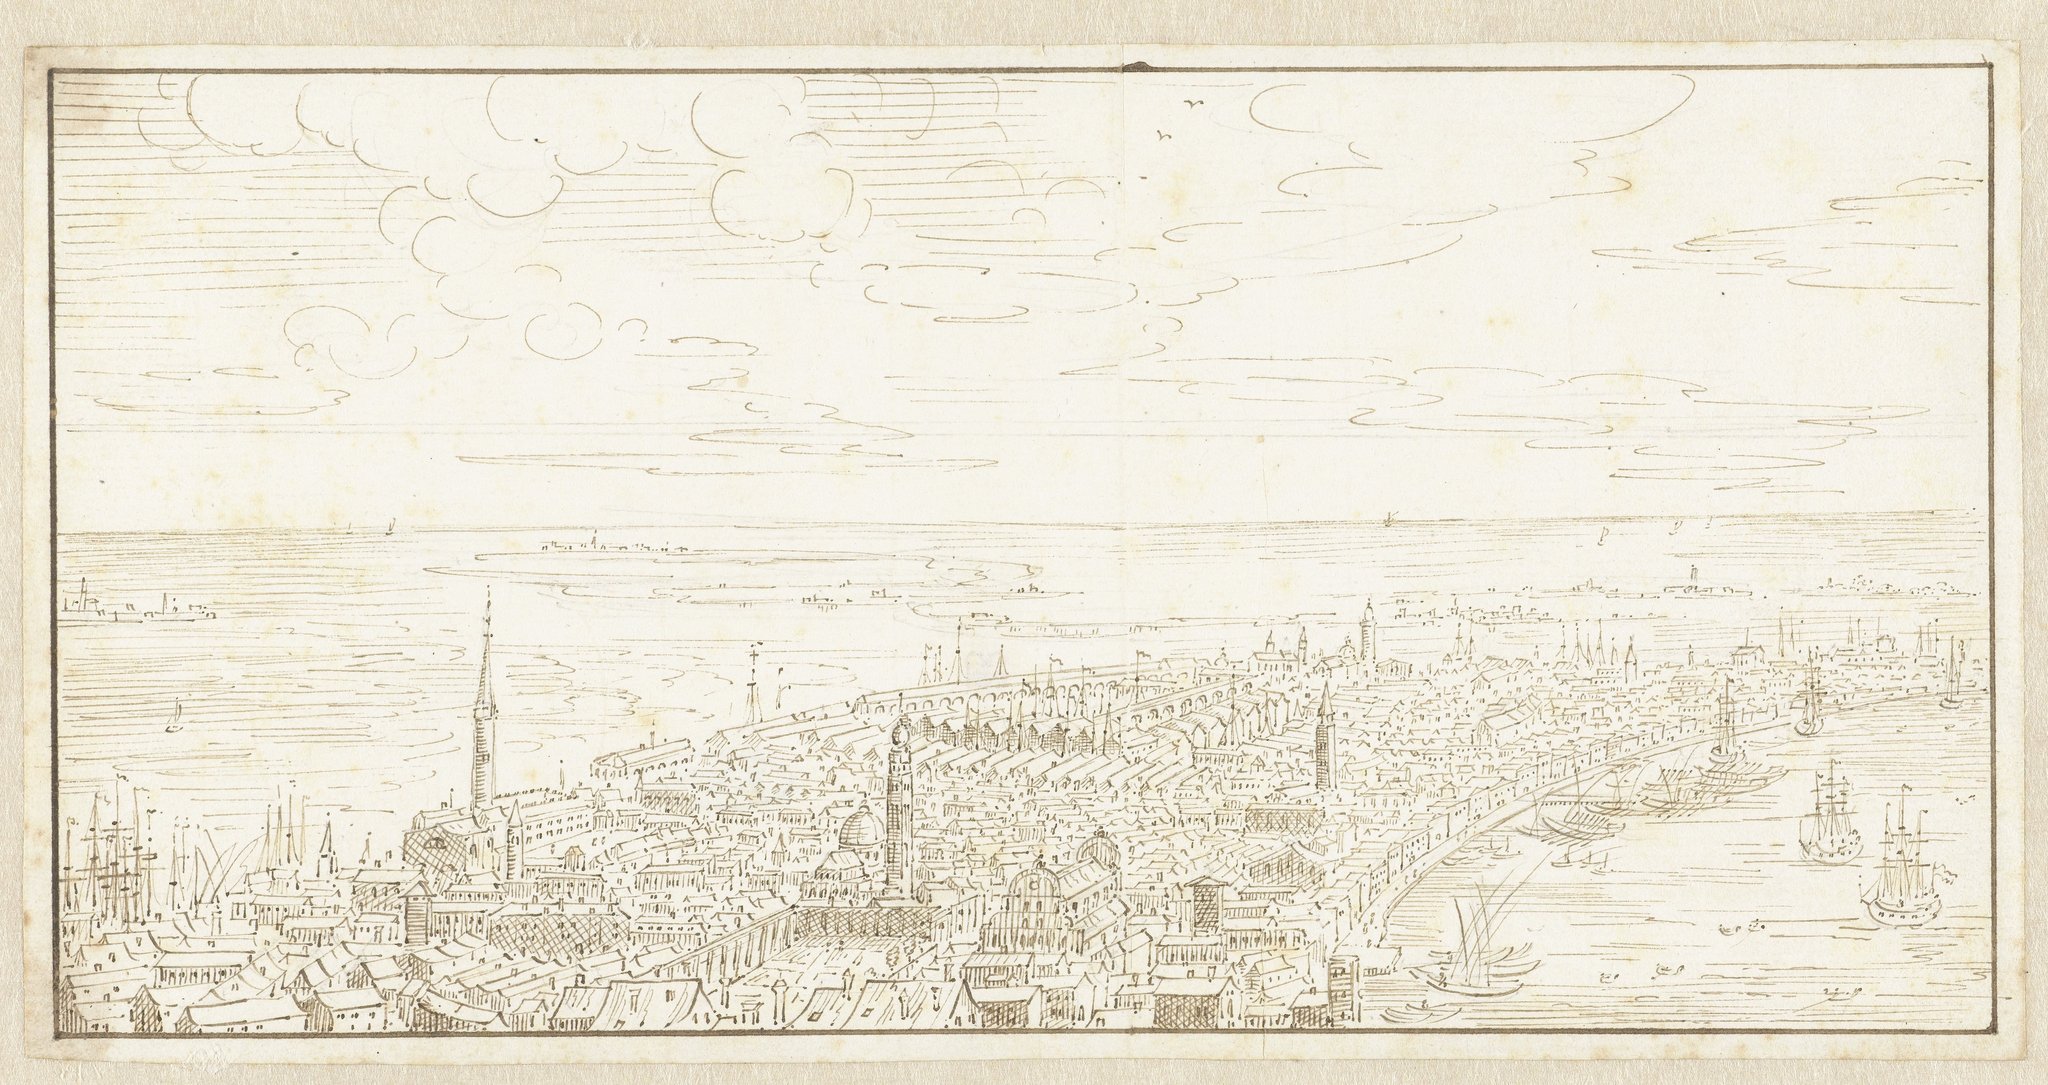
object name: drawing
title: Gezichten rond de Middellandse Zee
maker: johan teyler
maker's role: draughtsman, print maker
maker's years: 1648-1712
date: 1679-1683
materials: ink, paper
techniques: pen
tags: prospect of city, town panorama, silhouette of city